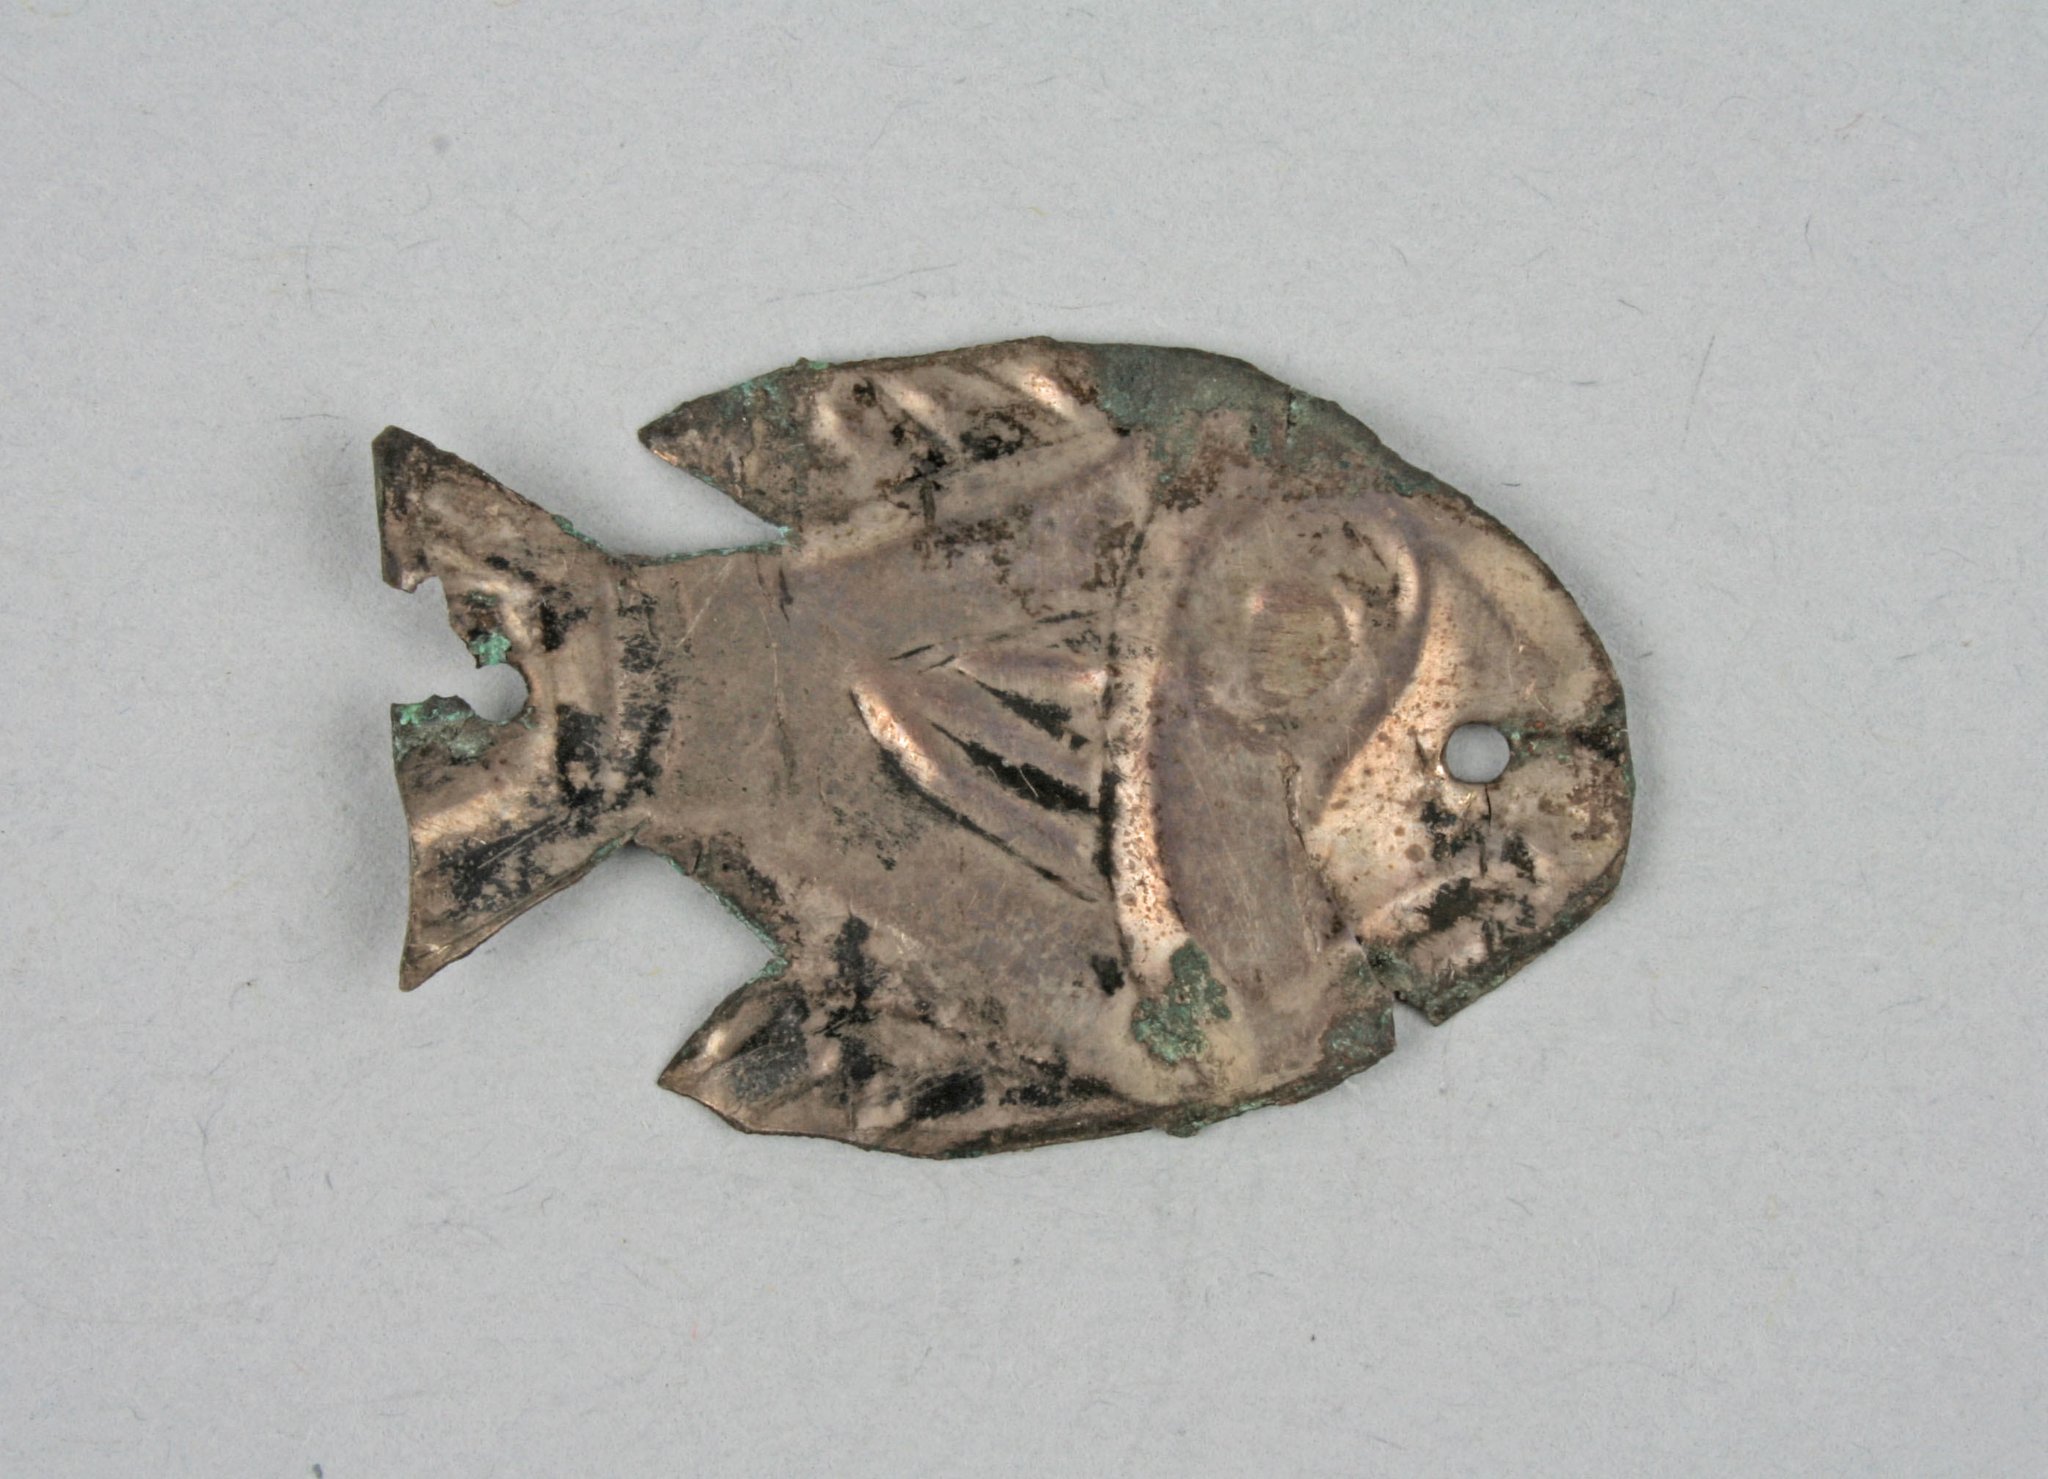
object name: costume ornament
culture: central coast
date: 1001-1200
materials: silver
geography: peru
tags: fish